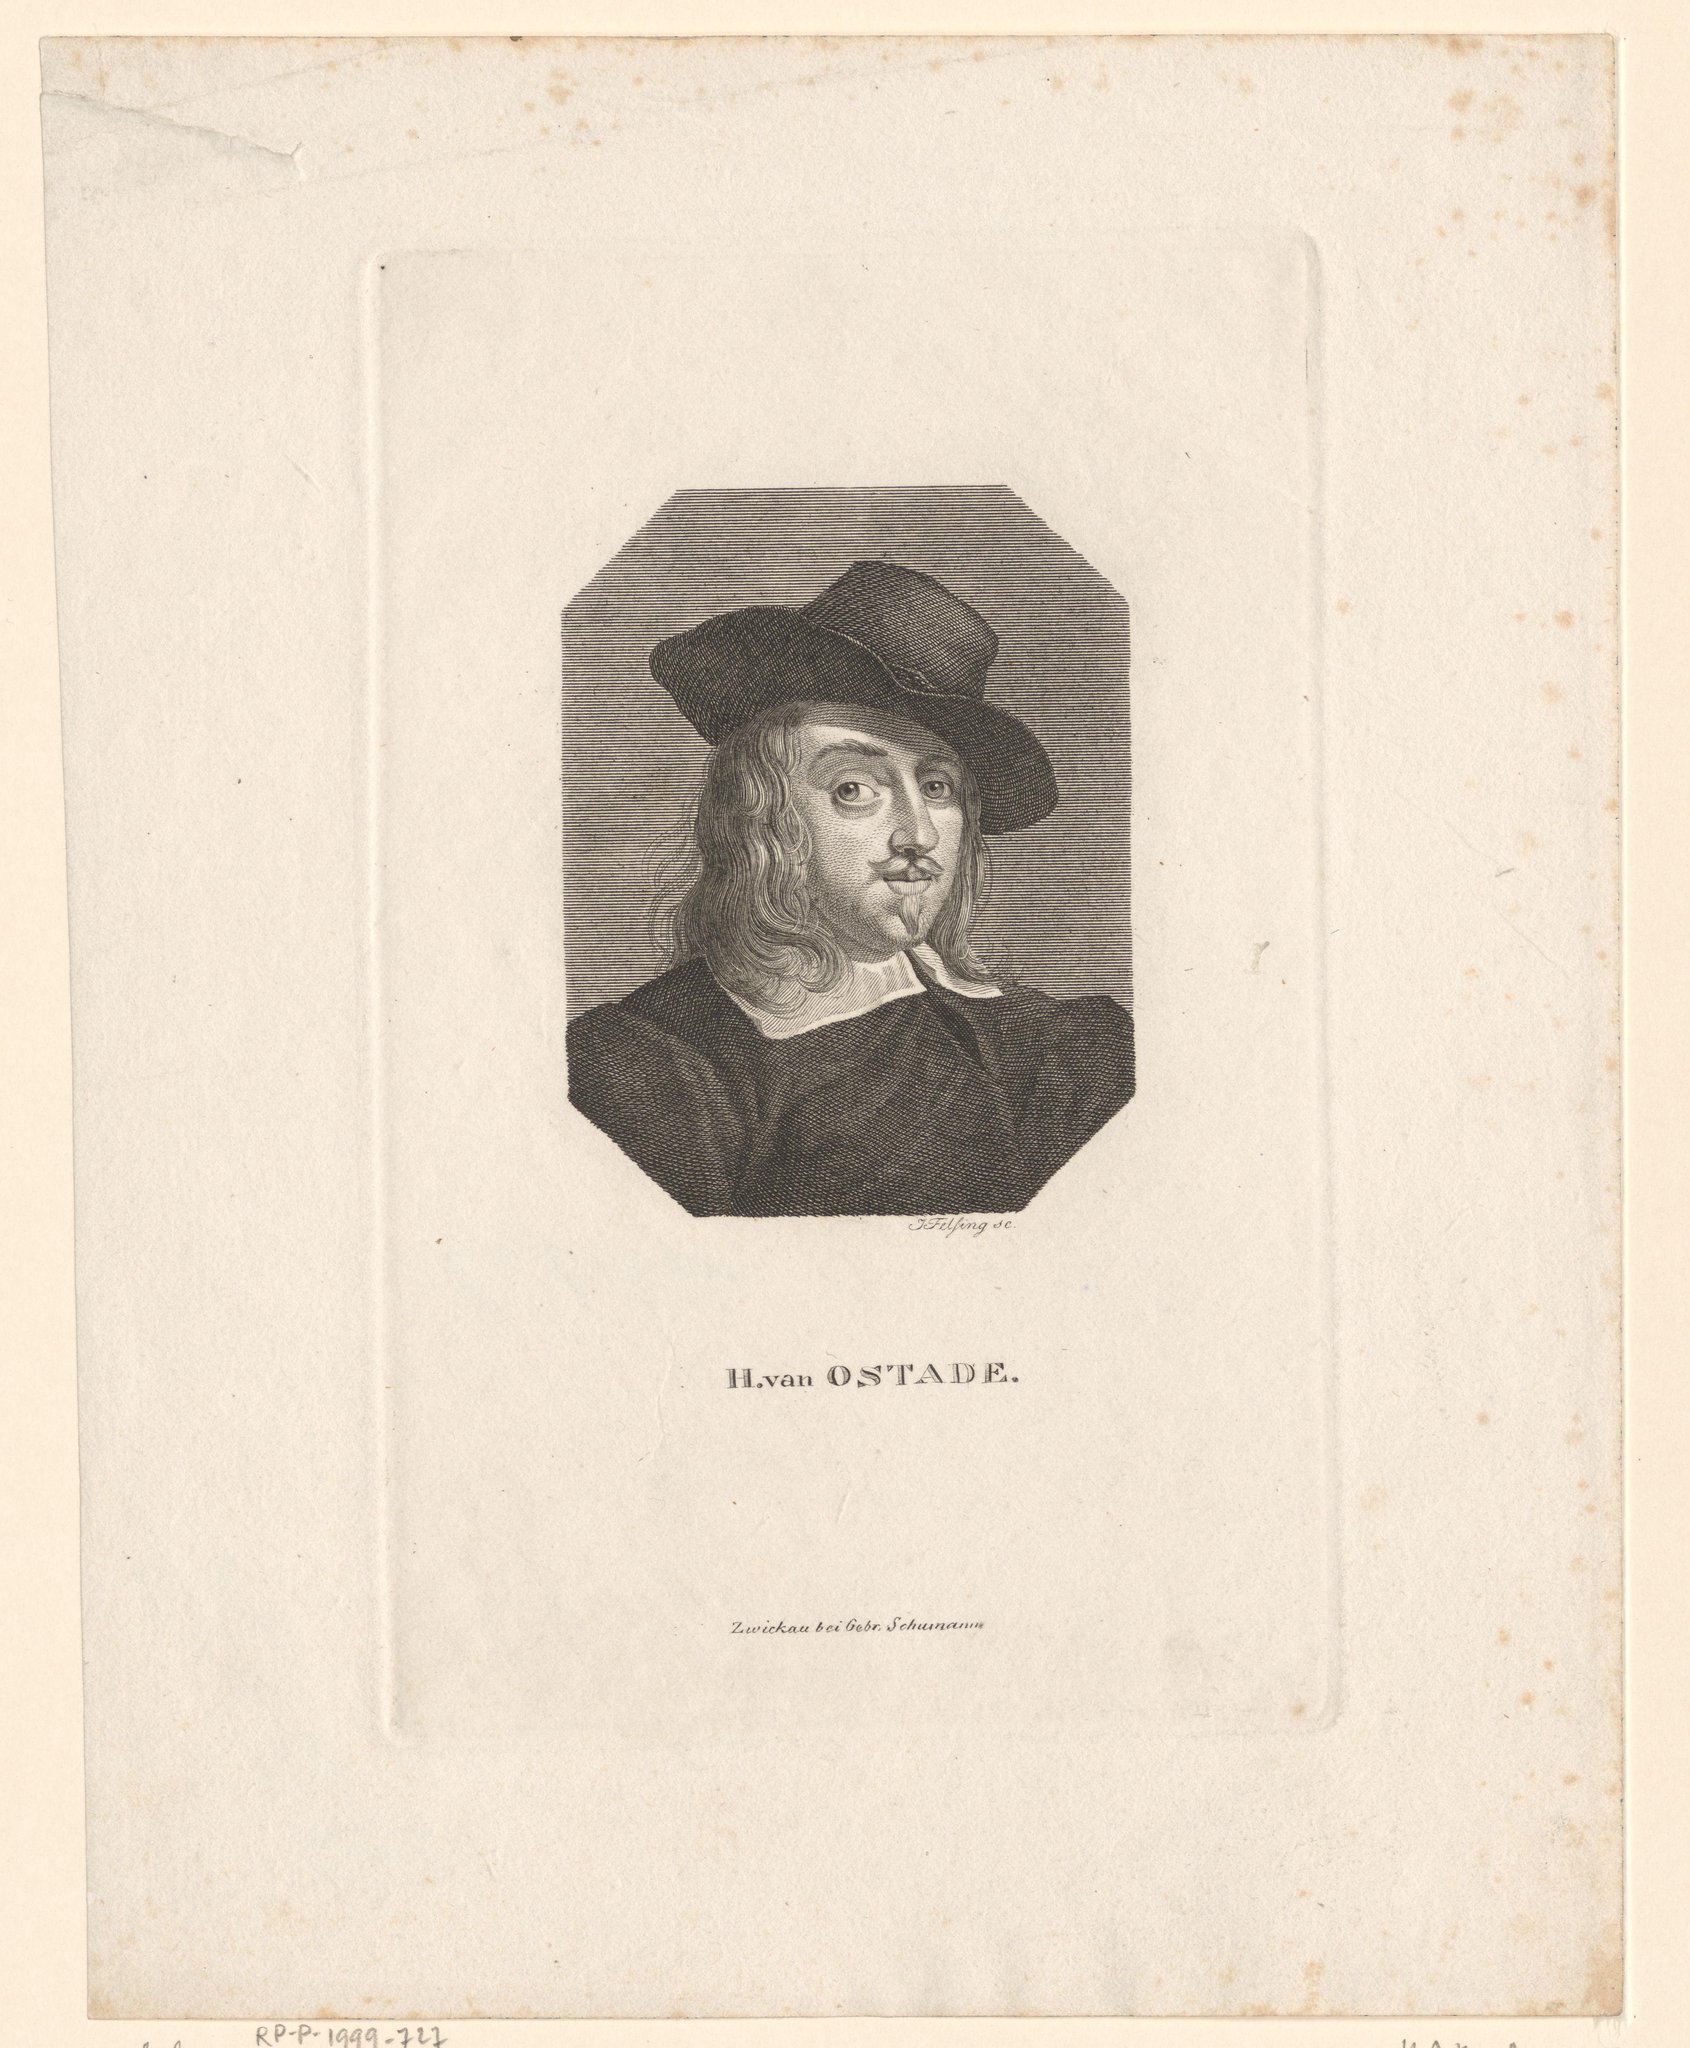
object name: print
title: Portret van Adriaen van Ostade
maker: jan jacob fels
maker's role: print maker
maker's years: 1816-1883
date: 1832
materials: paper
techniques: engraving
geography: zwickau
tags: haarlem, painter, adriaen van ostade, historical persons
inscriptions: collector's mark: Lugt 2228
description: Prent mogelijk uit: Bildnisse der berühmtesten Menschen aller Völker und Zeiten (...). Zwickau: gebroeders Schumann, 1832